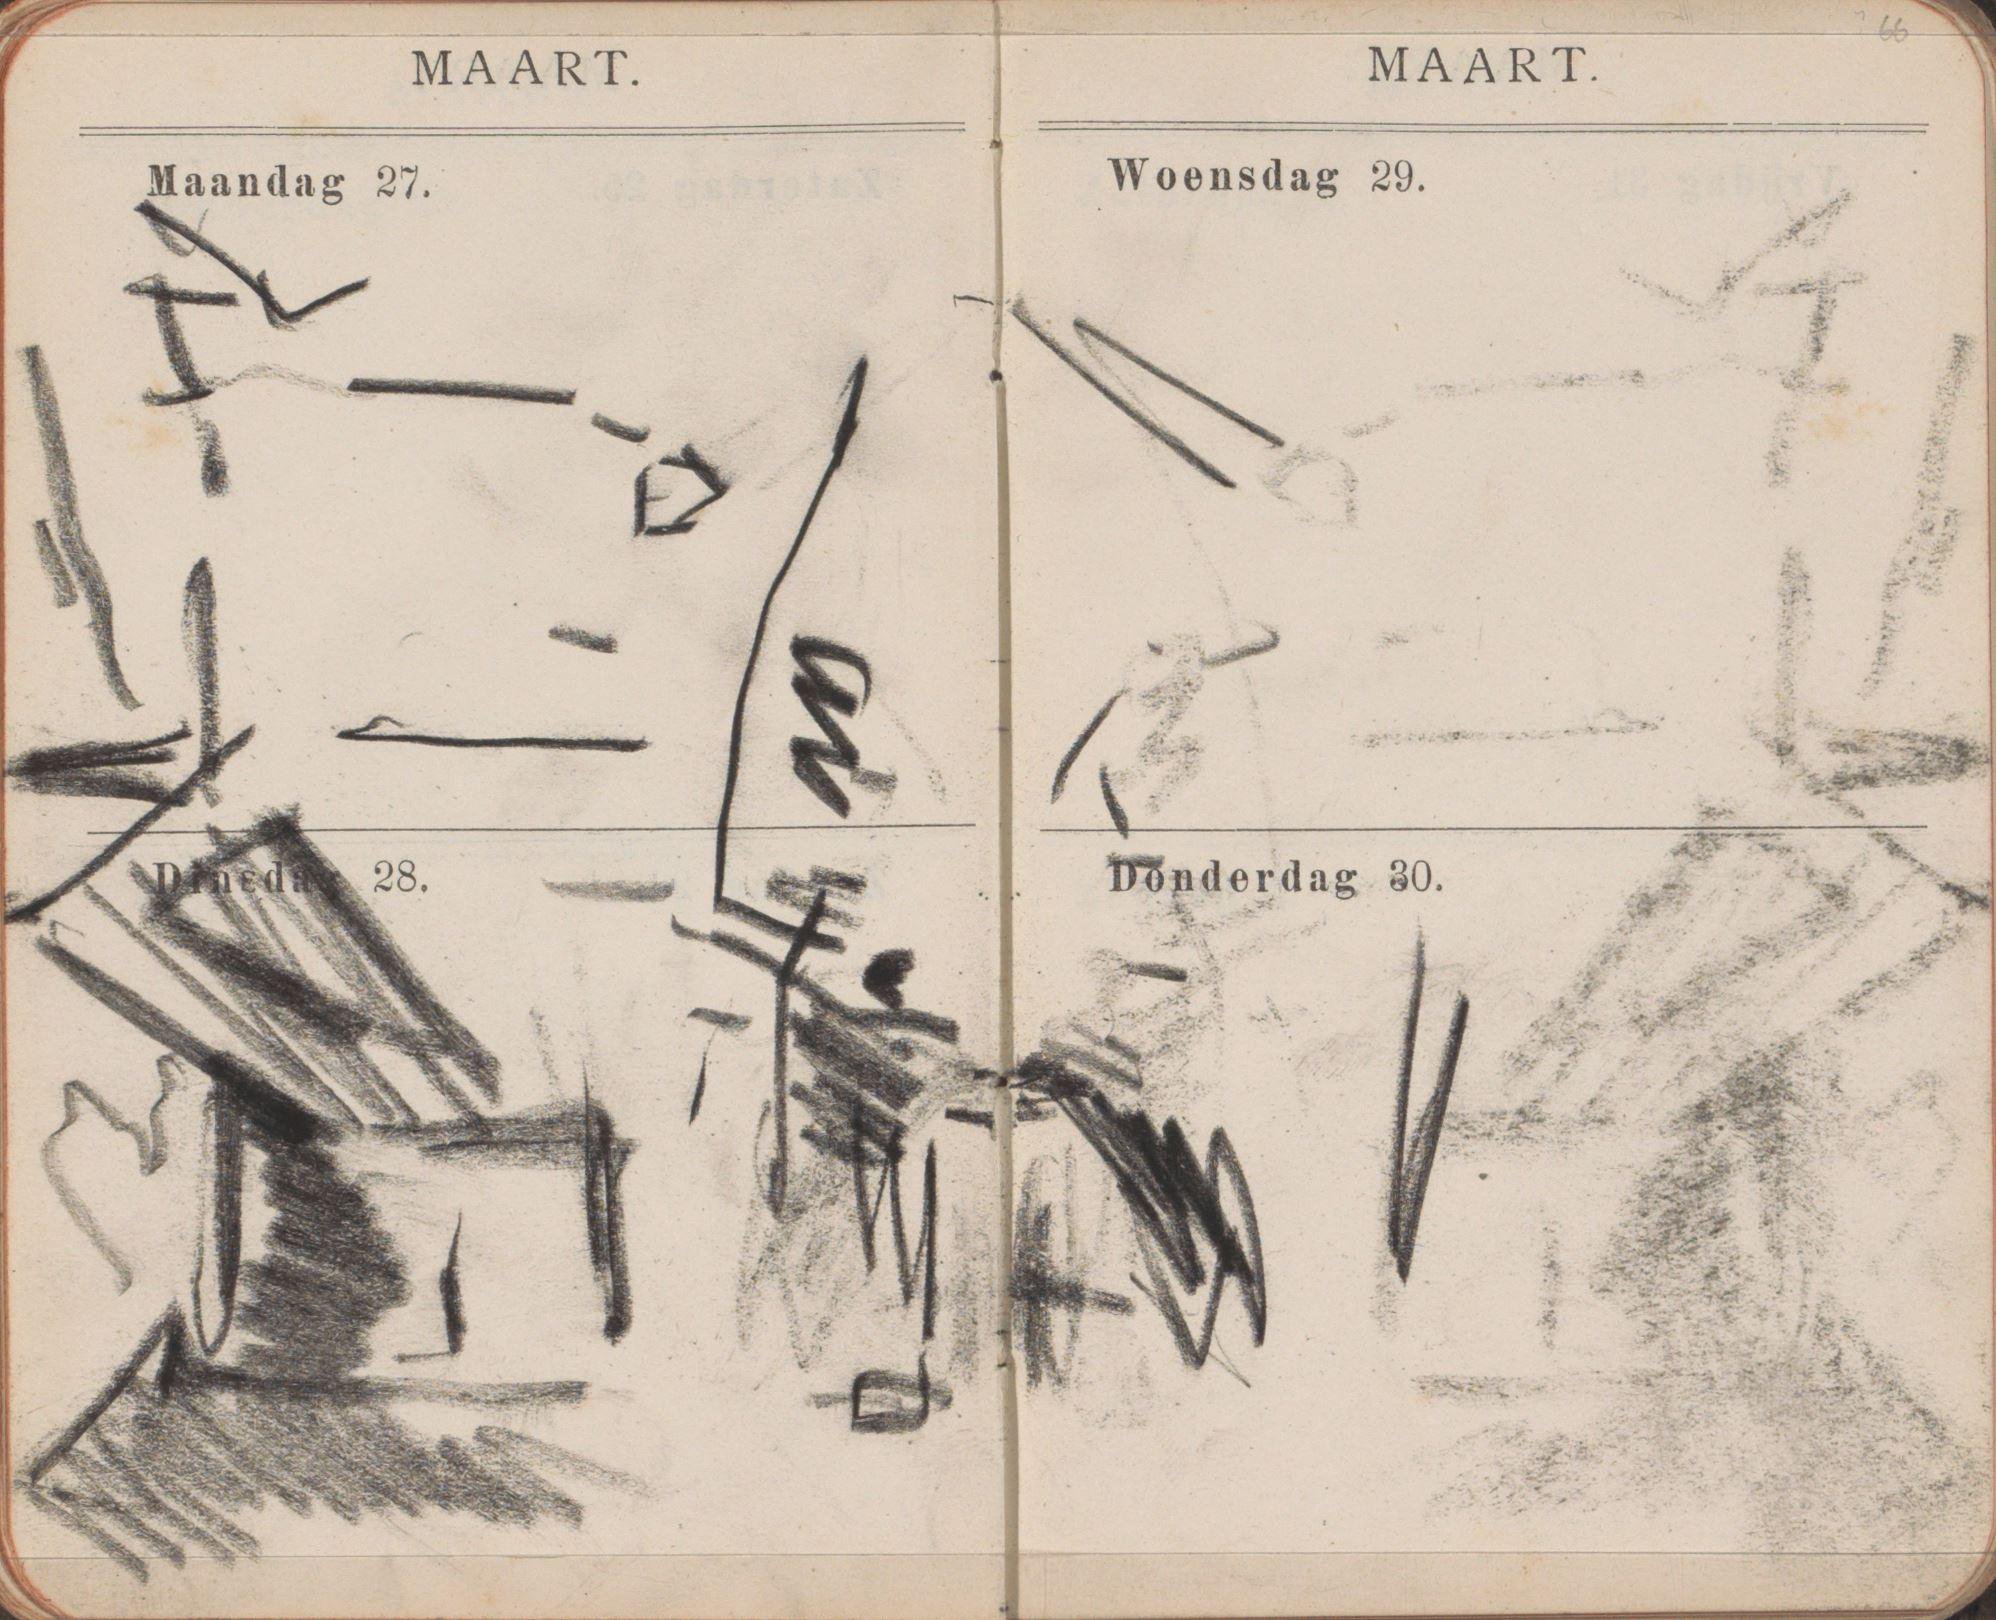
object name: sketchbook leaf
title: Gezicht op de Dam te Amsterdam met de Nieuwe Kerk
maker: george hendrik breitner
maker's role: draughtsman, painter, print maker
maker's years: 1857-1923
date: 1893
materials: chalk, paper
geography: amsterdam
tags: square, place, circus, etc., church (exterior), royal palace of amsterdam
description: Links een deel van het Koninklijk Paleis. Pagina 65 en pagina 66 uit een als schetsboek gebruikte agenda met 108 bladen.